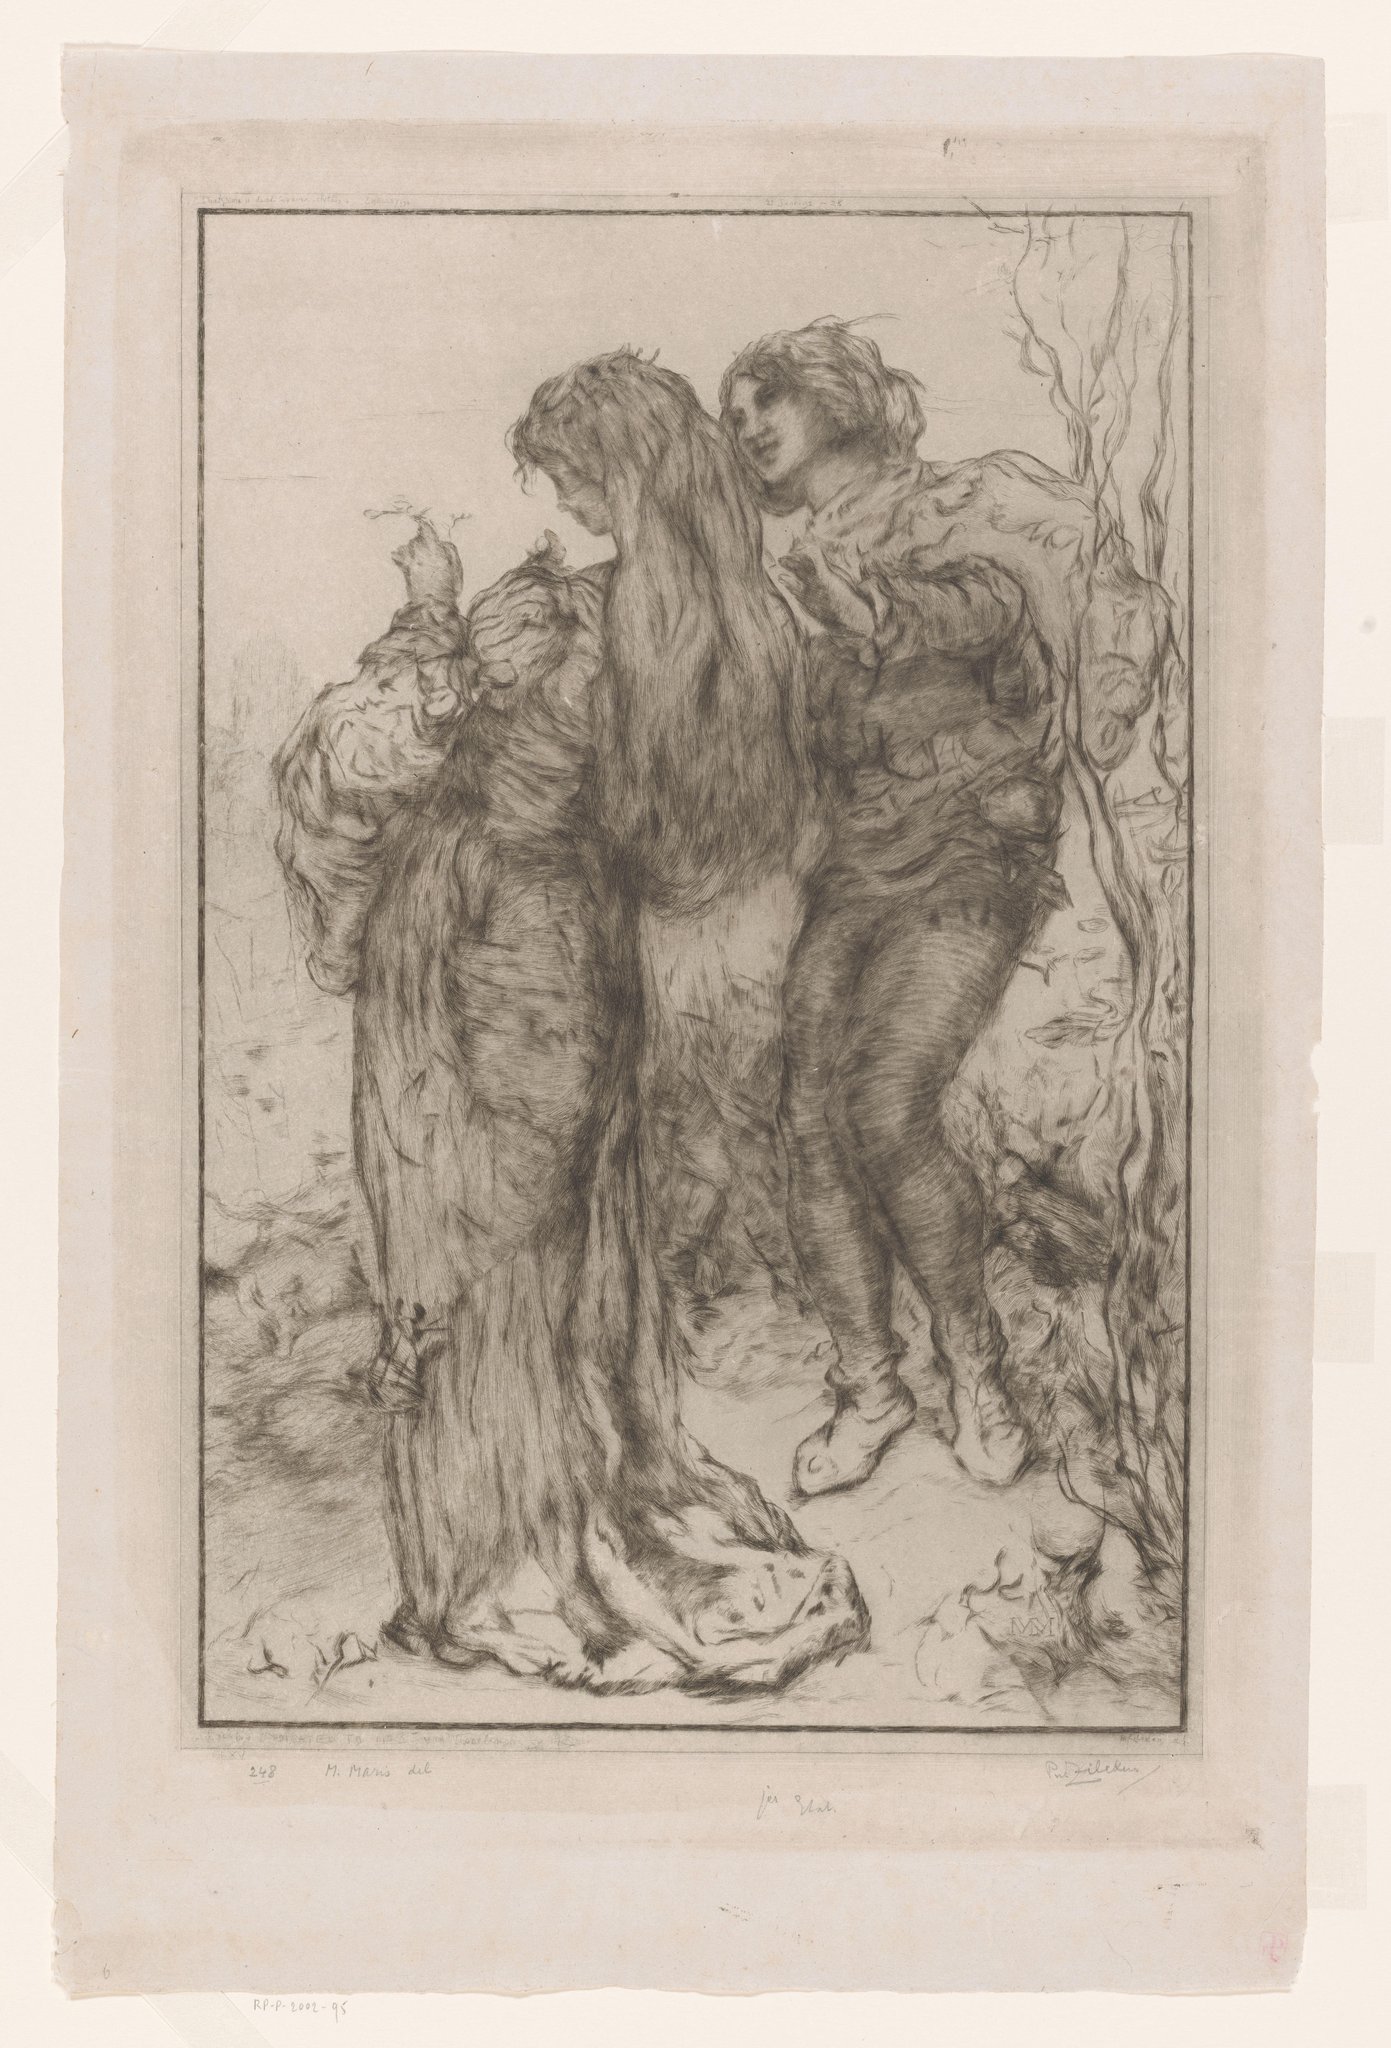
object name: print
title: The King's Children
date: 1857-1912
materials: paper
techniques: etching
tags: historical costume, couple of lovers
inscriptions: collector's mark: ‘Monogram JPH’, collector's mark: Lugt 2760, collector's mark: Lugt 2228, annotation: ‘1er Etat’, signature: ‘Etching dedicated to Mr. E.J. van Wisselingh’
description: De tekening waarop deze prent gebaseerd is was bekend in 1898 (opgenomen in studie van Lodewijk van Deyssel). De opdracht aan Van Wisselingh suggereert een datering vóór 1912 (jaar van overlijden Wisselingh).